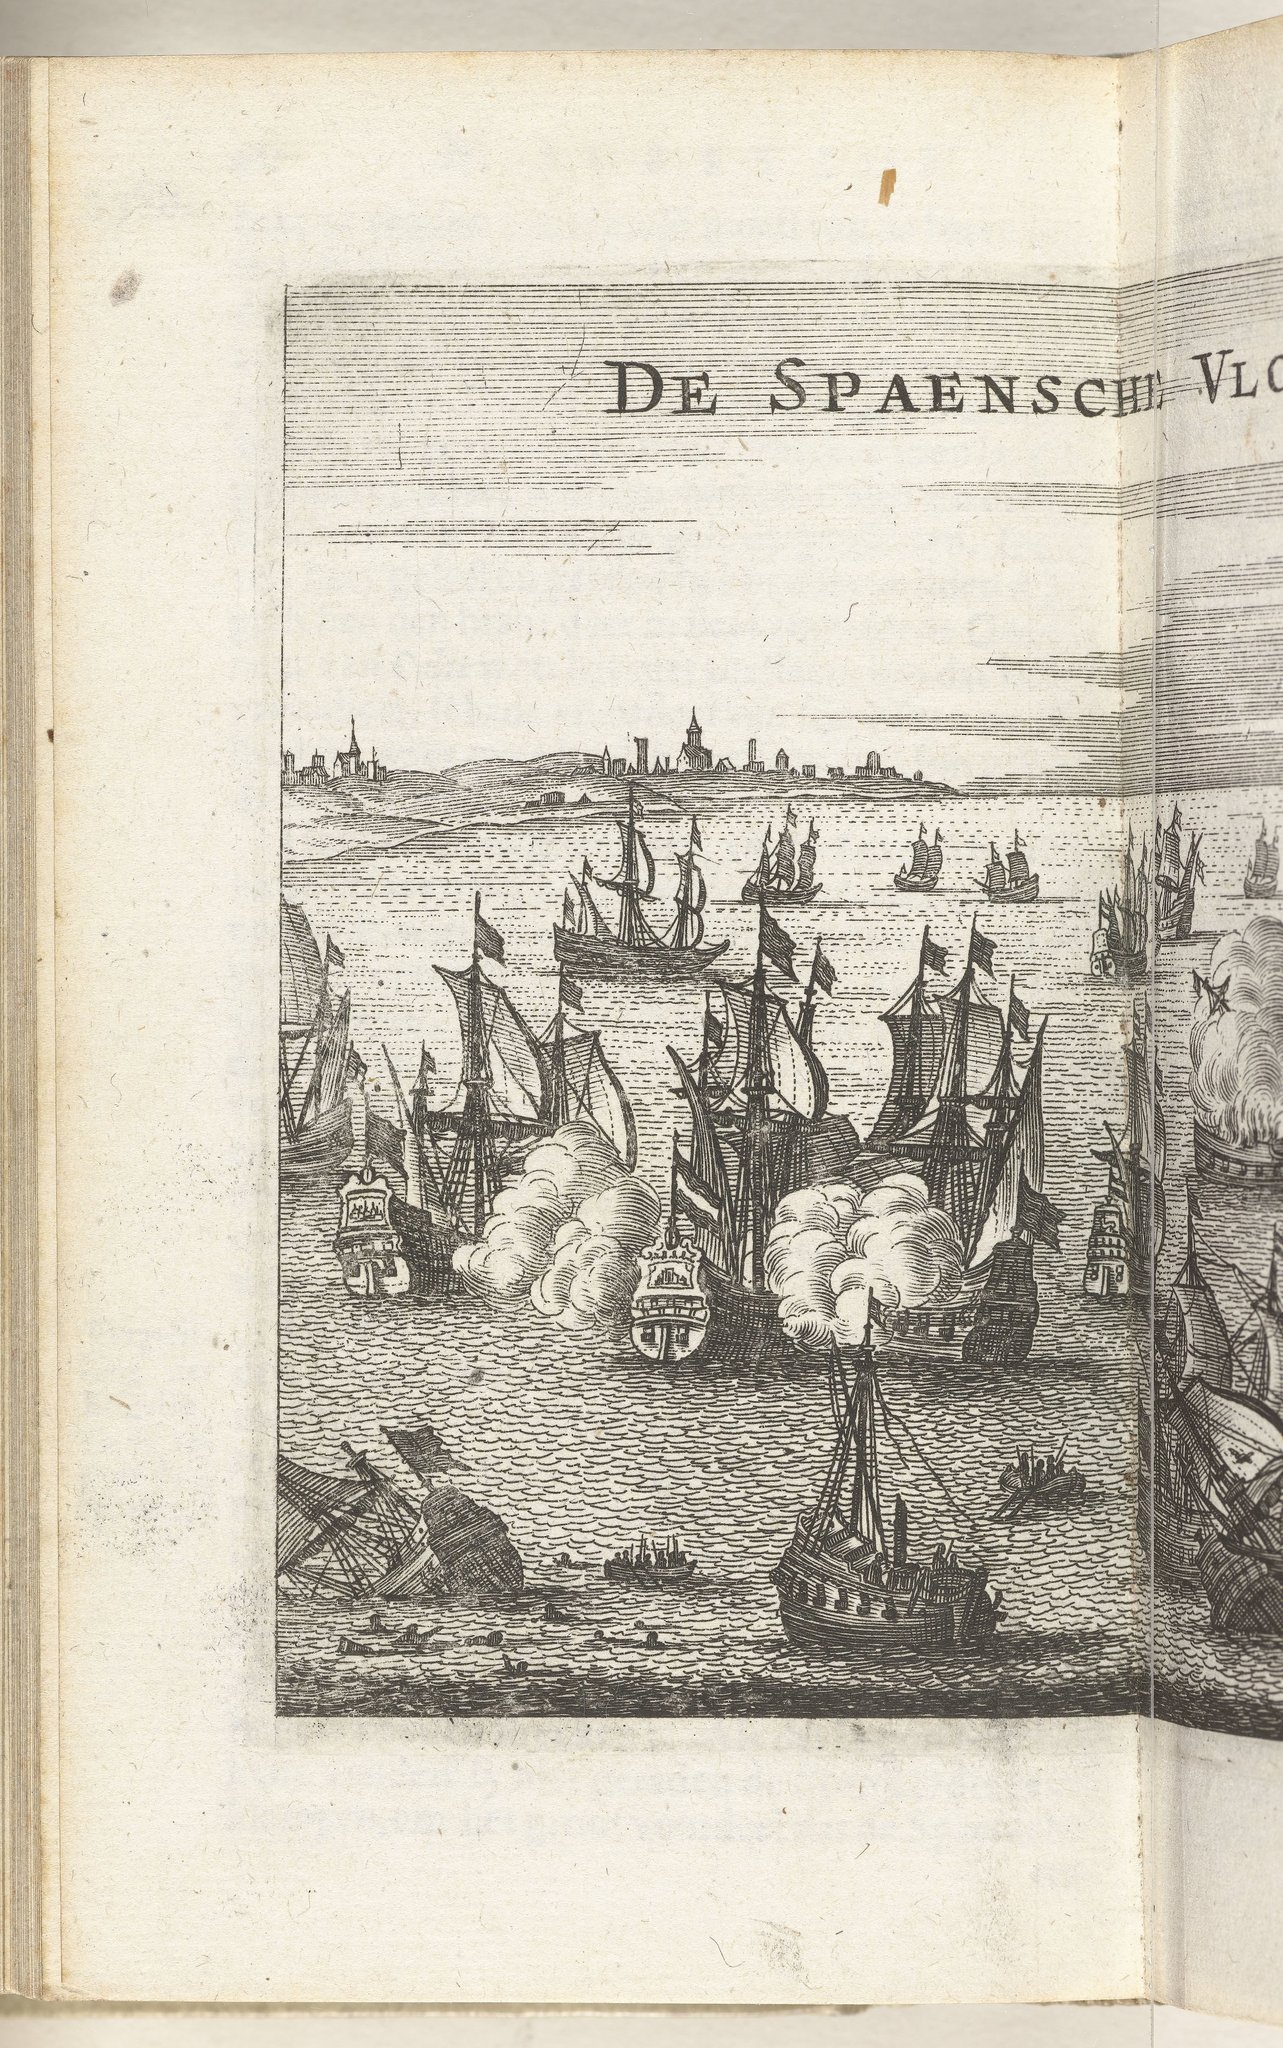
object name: history print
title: De Spaensche Vloot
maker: Anonymous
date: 1662-1664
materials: paper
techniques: etching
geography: northern netherlands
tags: battle (+ naval force)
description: Illustratie in: A. Montanus, 'T leven en bedryf der prinsen van Oranje, Wilhelm de eerste, Maurits, Frederik Henrik, Wilhem de tweede, Wilhem de derde : aengehecht met de daden der Nassouwsche stam, van het jaar 682 tot dese tyd, 5 delen in 2 banden, A. Montanus, Amsterdam 1664. Band I: deel Maurits, p. 40-41. In het exemplaar in de collectie van de Rijksmuseum Research Library (330 F 12-13).